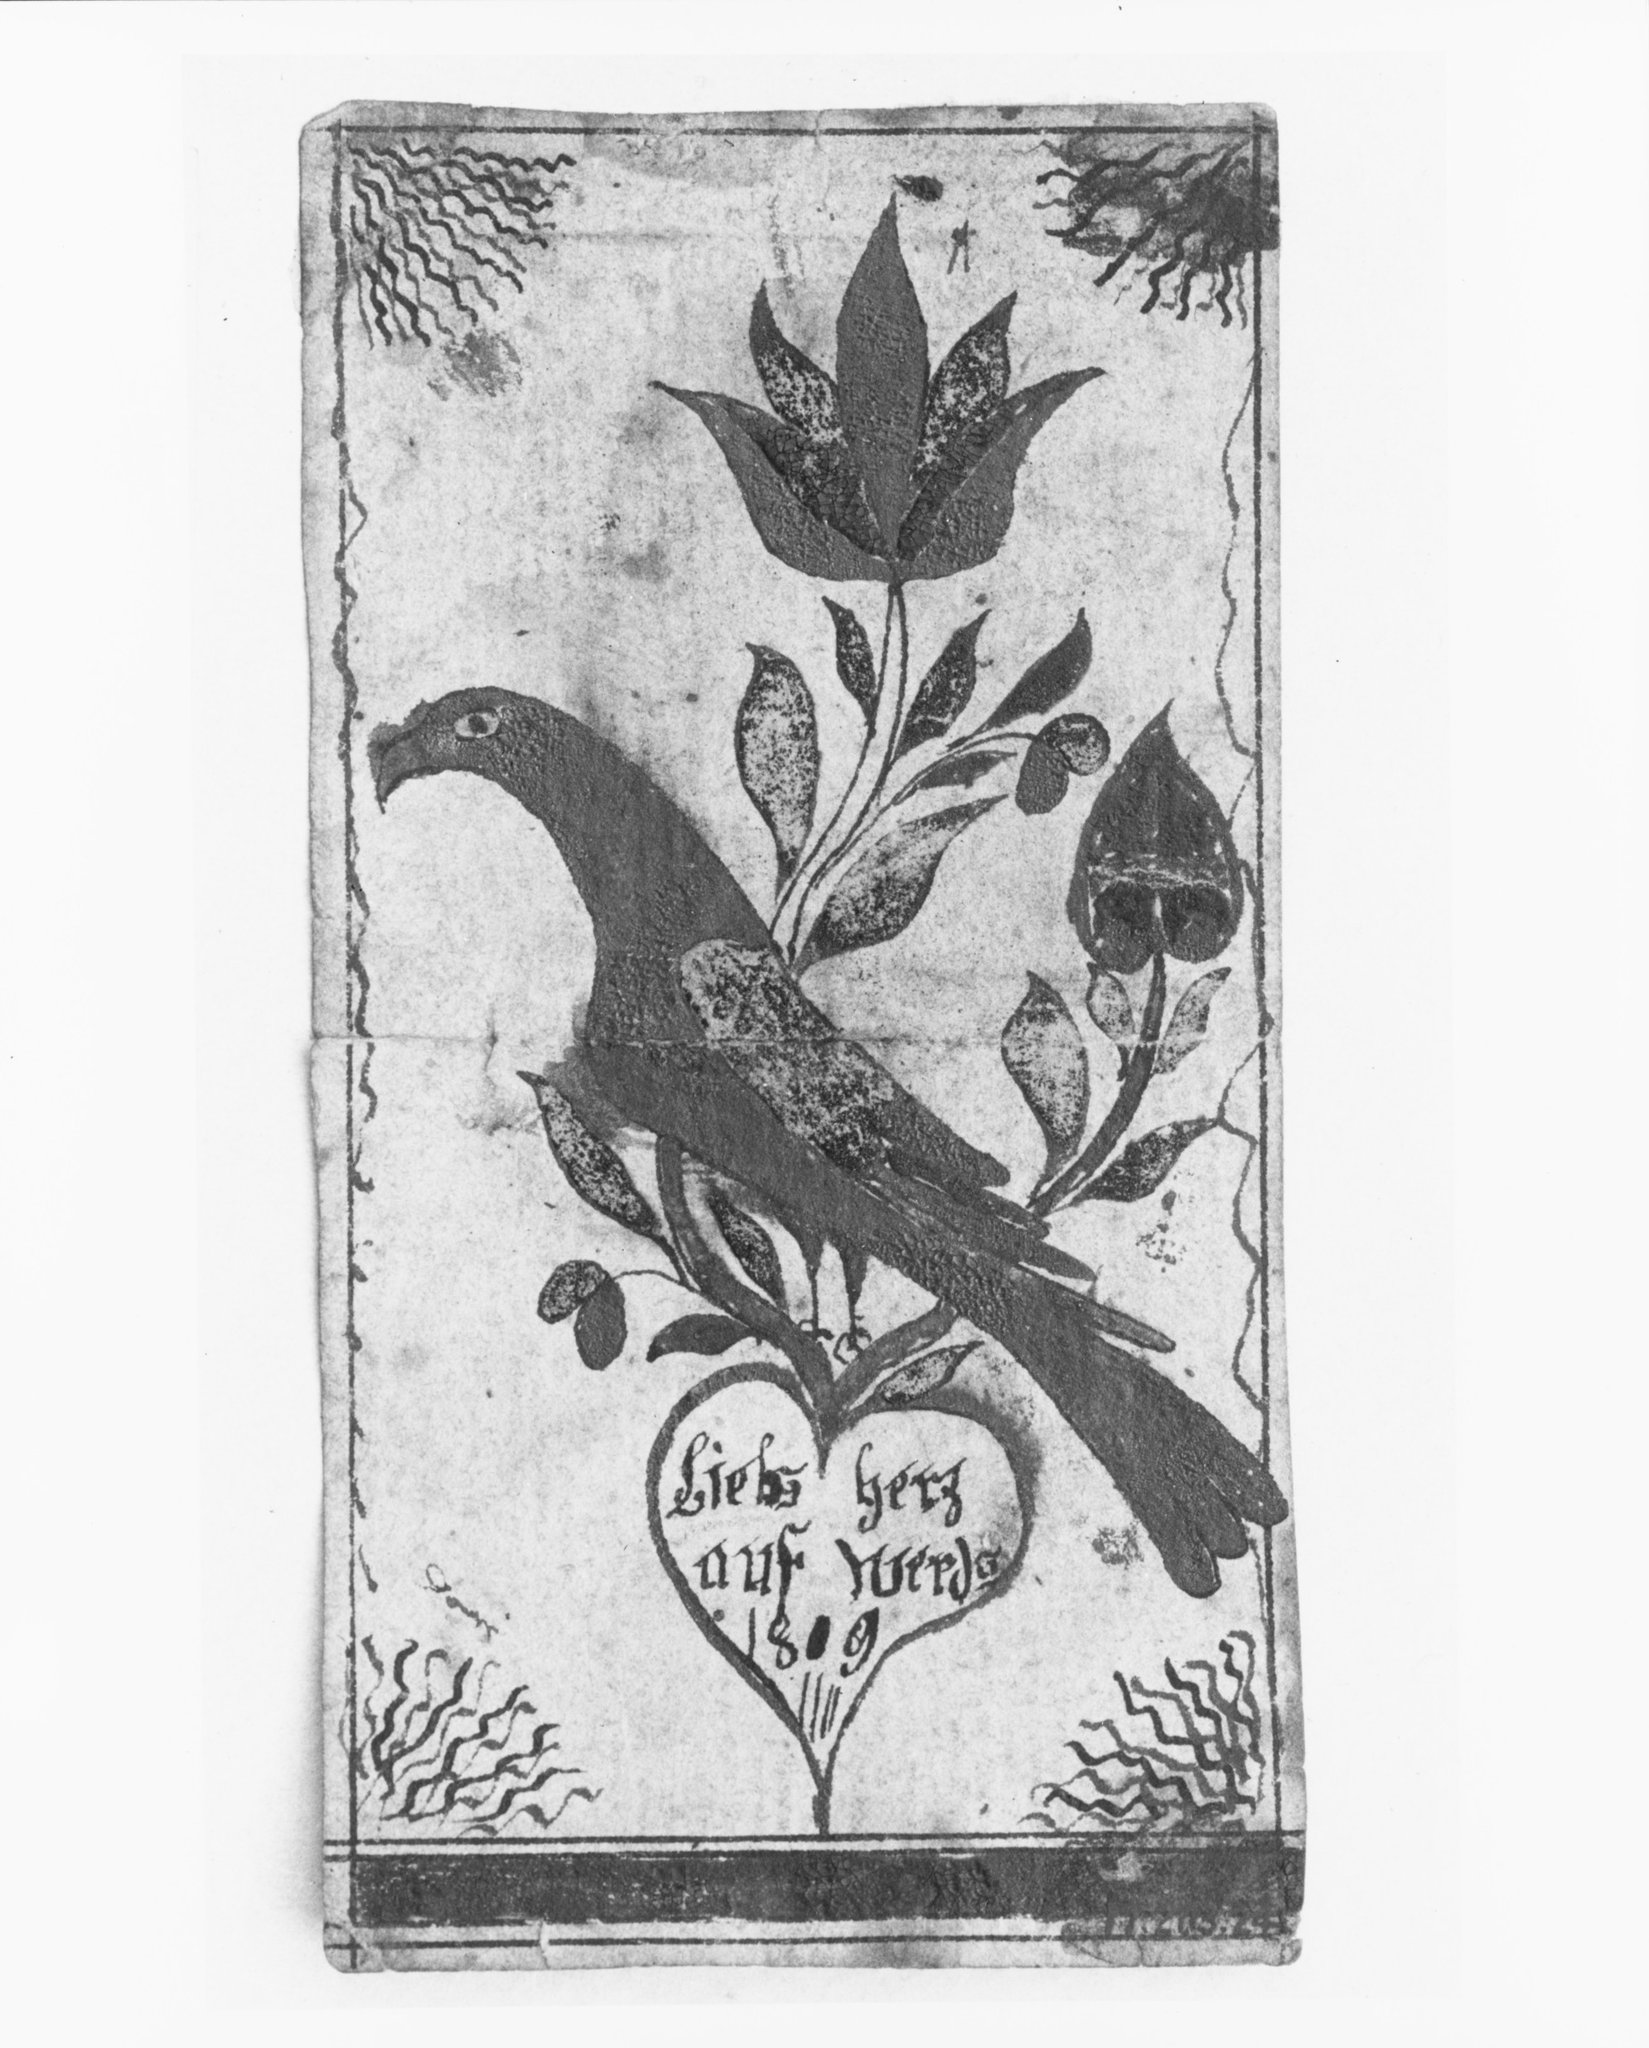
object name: card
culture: american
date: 1809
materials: paper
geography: united states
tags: birds,flowers,leaves